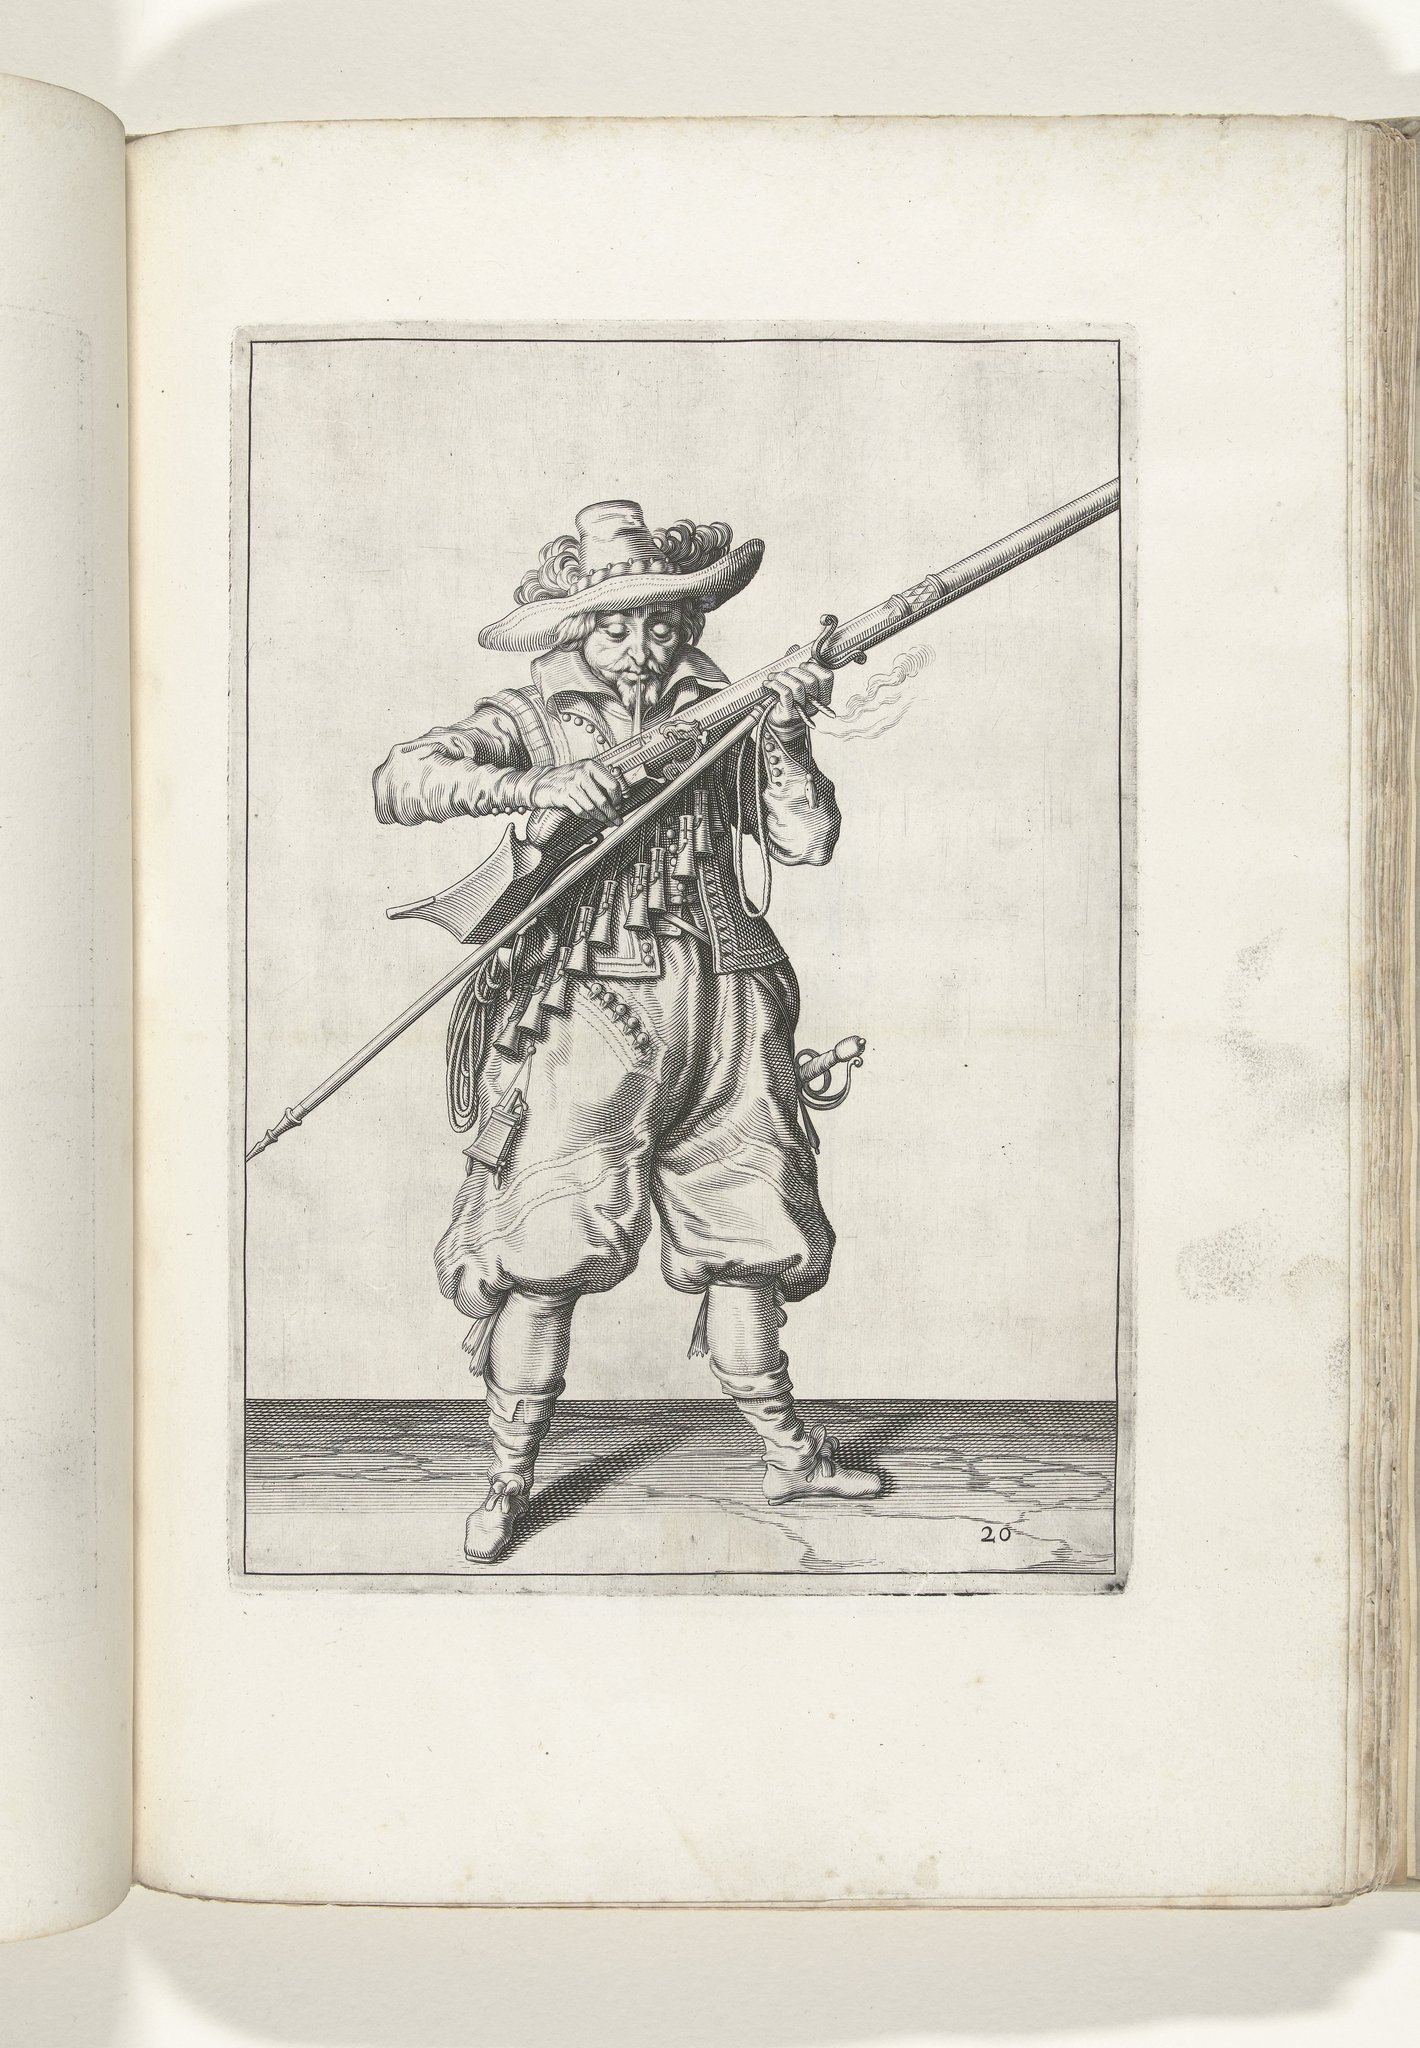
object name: print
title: Soldaat die kruit van zijn musket blaast (nr. 20), ca. 1600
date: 1597-1607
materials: paper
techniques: engraving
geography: northern netherlands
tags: the hague, maurice (prince of orange), handling of weapons ~ military training, weapons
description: Een soldaat, ten voeten uit, die met beide handen een musket (een bepaald type vuurwapen) bij zijn mond houdt en erover blaast, om eventueel buiten de pan (het kruitreservoir) gevallen kruit ervan af te krijgen (nr. 20), ca. 1600. In zijn linkerhand behalve de loop van het musket ook een furket (musketvork) en een brandende lont. Plaat 20 in de instructies voor het hanteren van het musket: Corte onderrechtinghe op de figuerliicke afbeeldinghe, soo veel aengaet het recht ghebruyck vant Musquet. Onderdeel van de illustraties in: J. de Gheyn, Wapenhandelinghe van Roers Musquetten ende spiessen, 's-Gravenhage, 1607. Krijgswezen rond 1600.